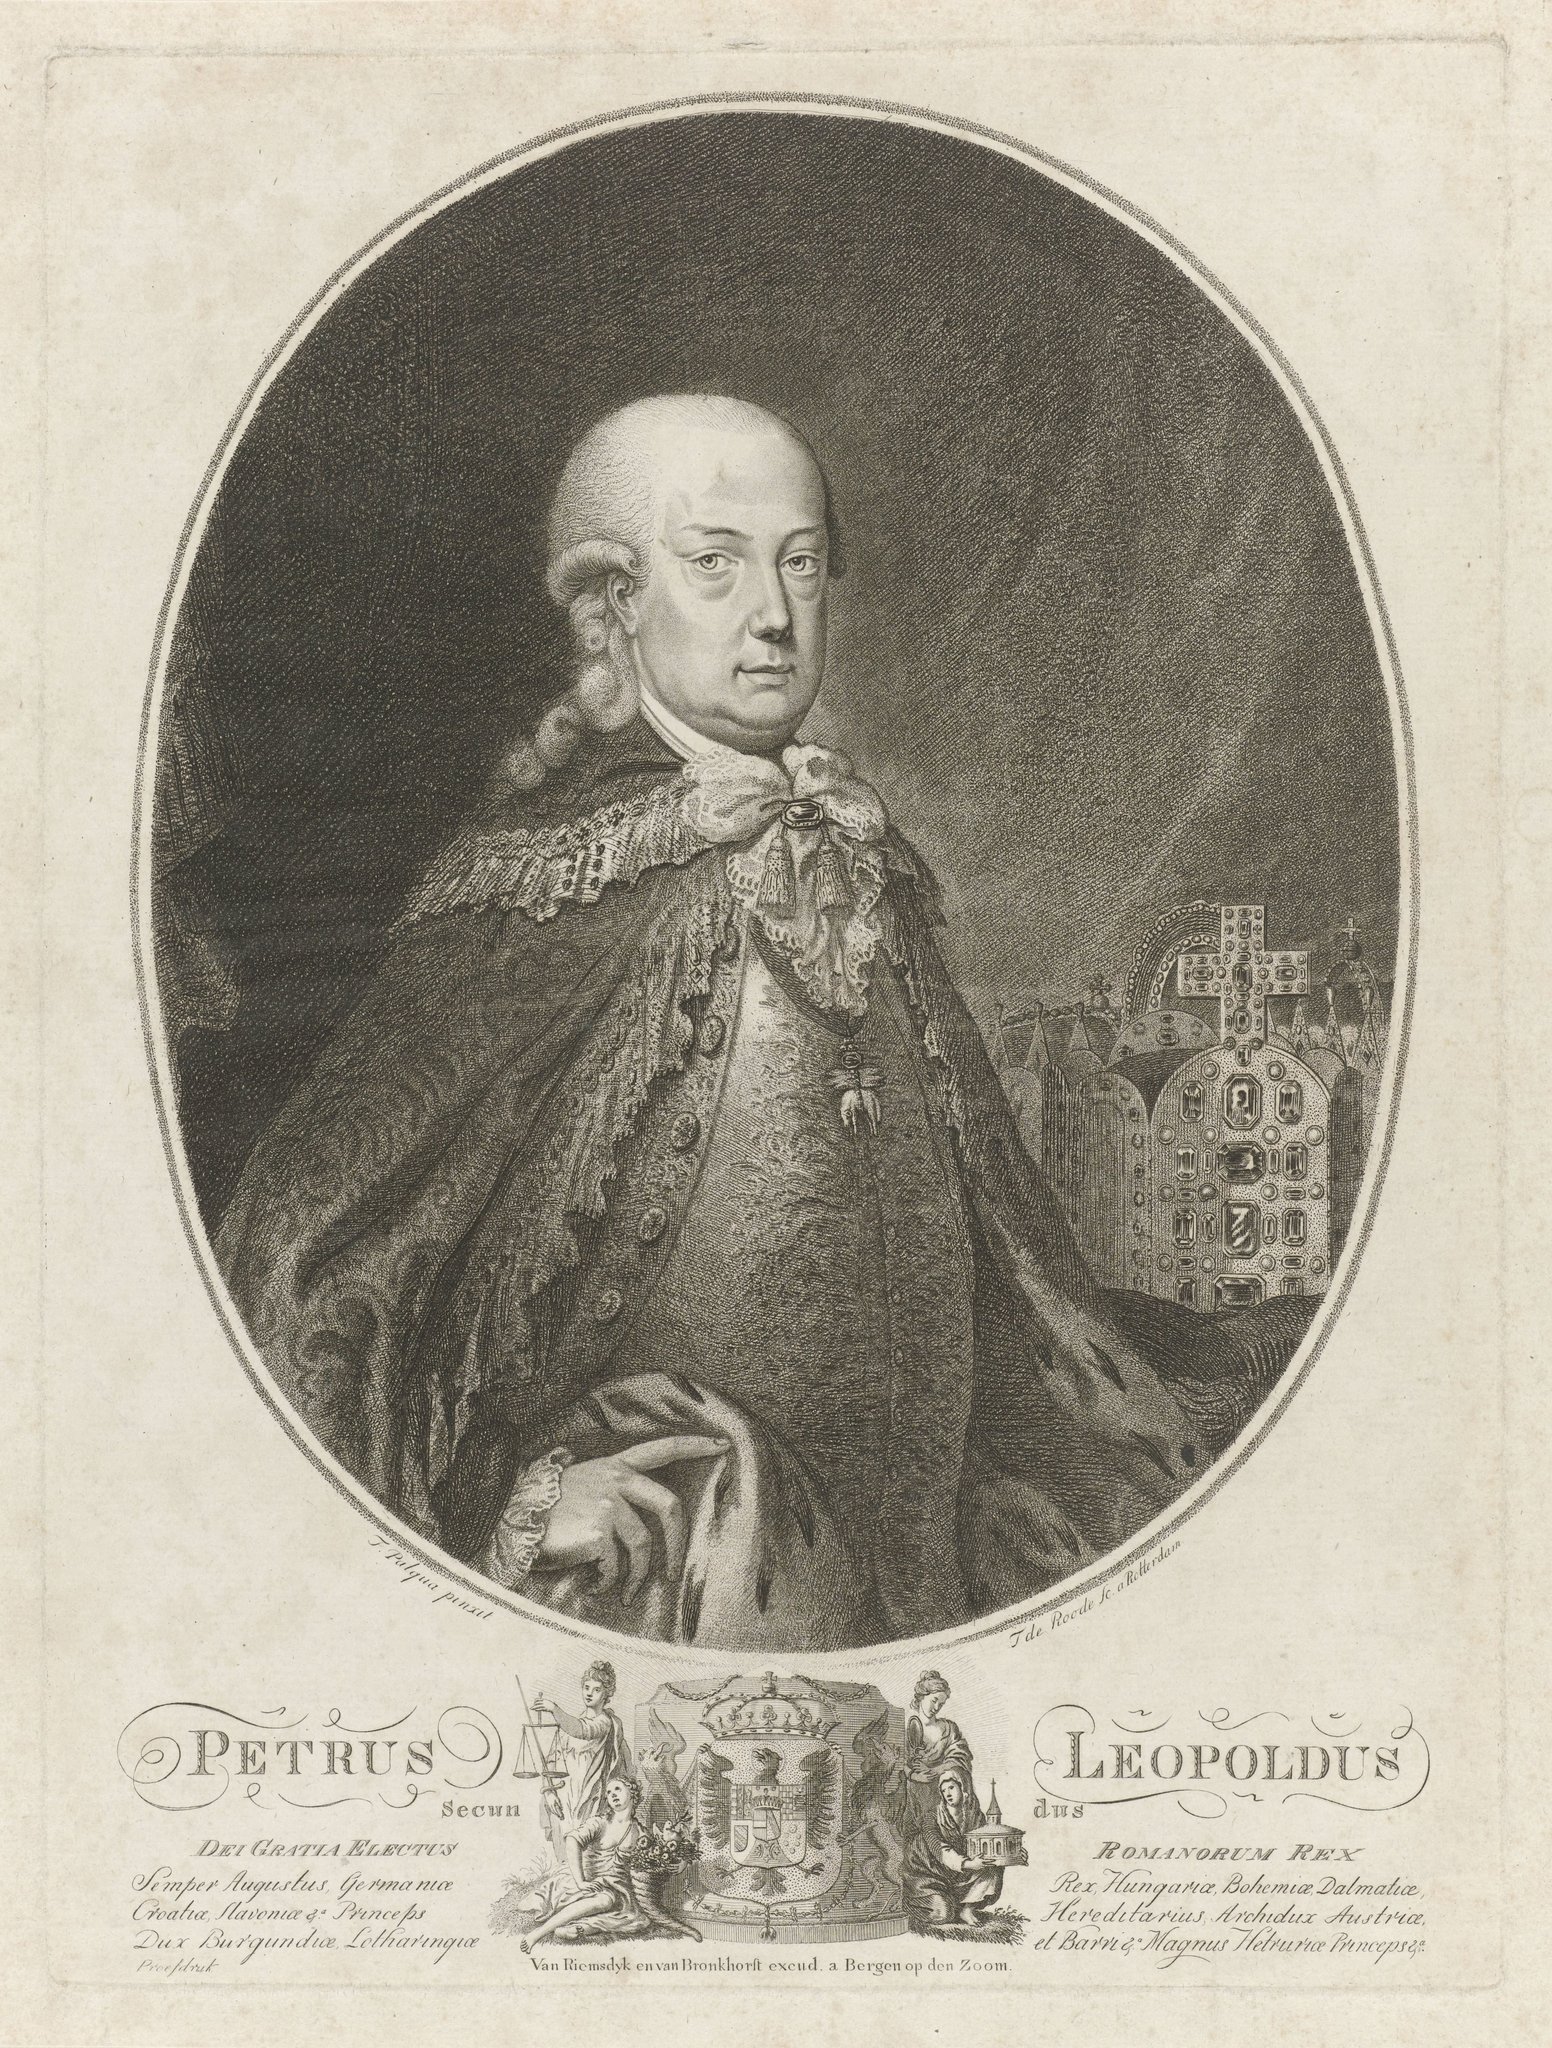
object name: print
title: Portret van Leopold II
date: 1790-1798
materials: paper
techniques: engraving, etching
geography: bergen op zoom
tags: vienna, leopold ii (keizer van oostenrijk), crown (symbol of sovereignty), knighthood order of the golden fleece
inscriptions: collector's mark: Lugt 2228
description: Portret van Leopold II, aartshertog van Oostenrijk, groothertog van Toscane, vorst van de Zuidelijke Nederlanden, koning van Bohemen en keizer van het Heilige Roomse Rijk. Aan een lint om de hals het embleem van de Orde van het Gulden Vlies, en naast hem een kroon. In de marge zijn familiewapen, zijn naam en titels.